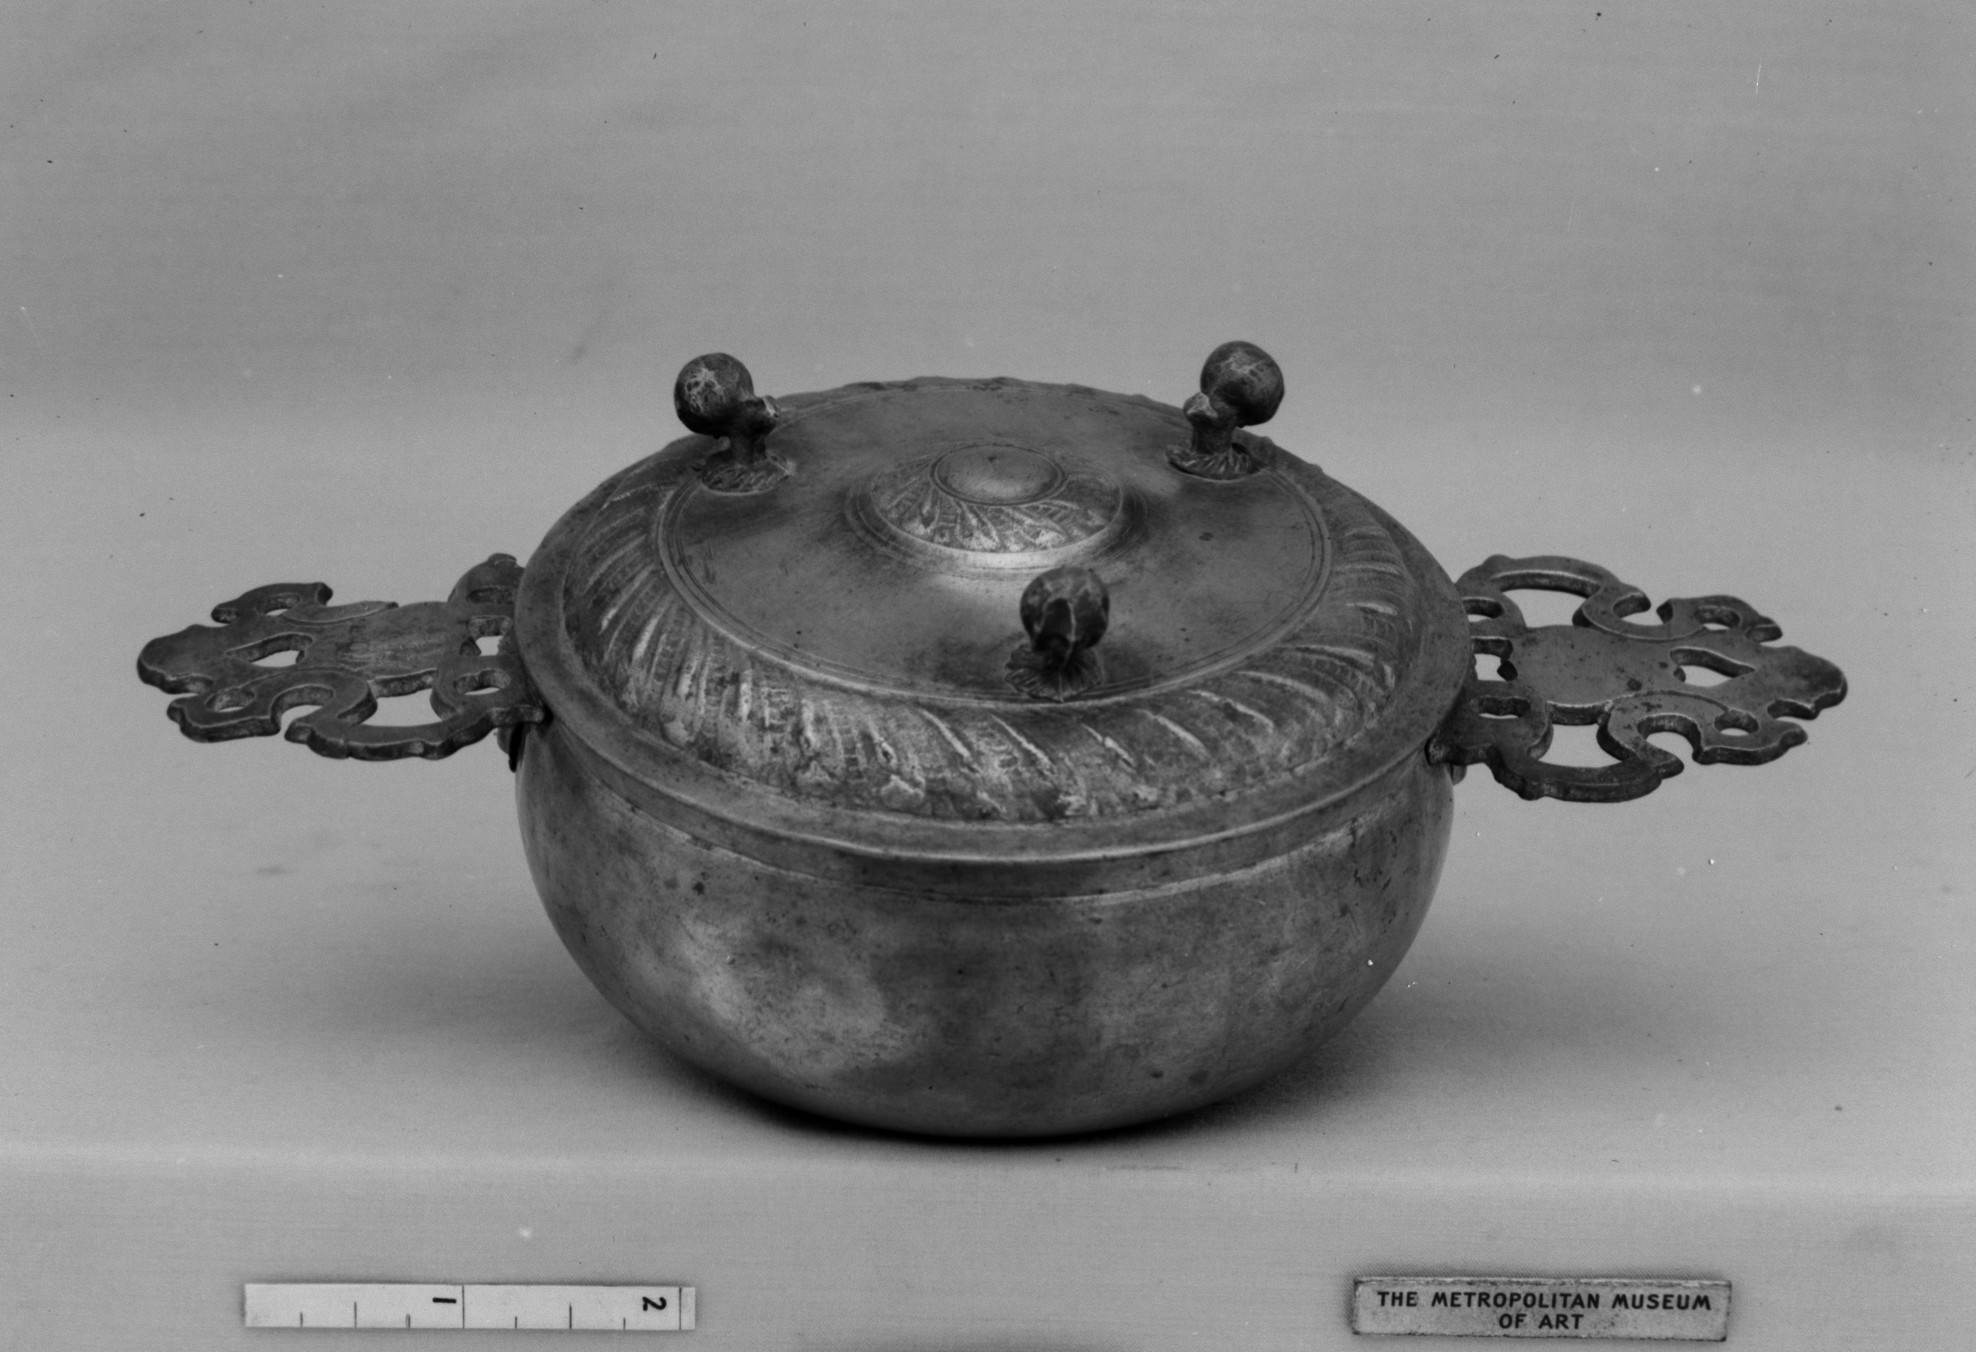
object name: porringer with cover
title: Porringer (Écuelle)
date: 1701-1800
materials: pewter